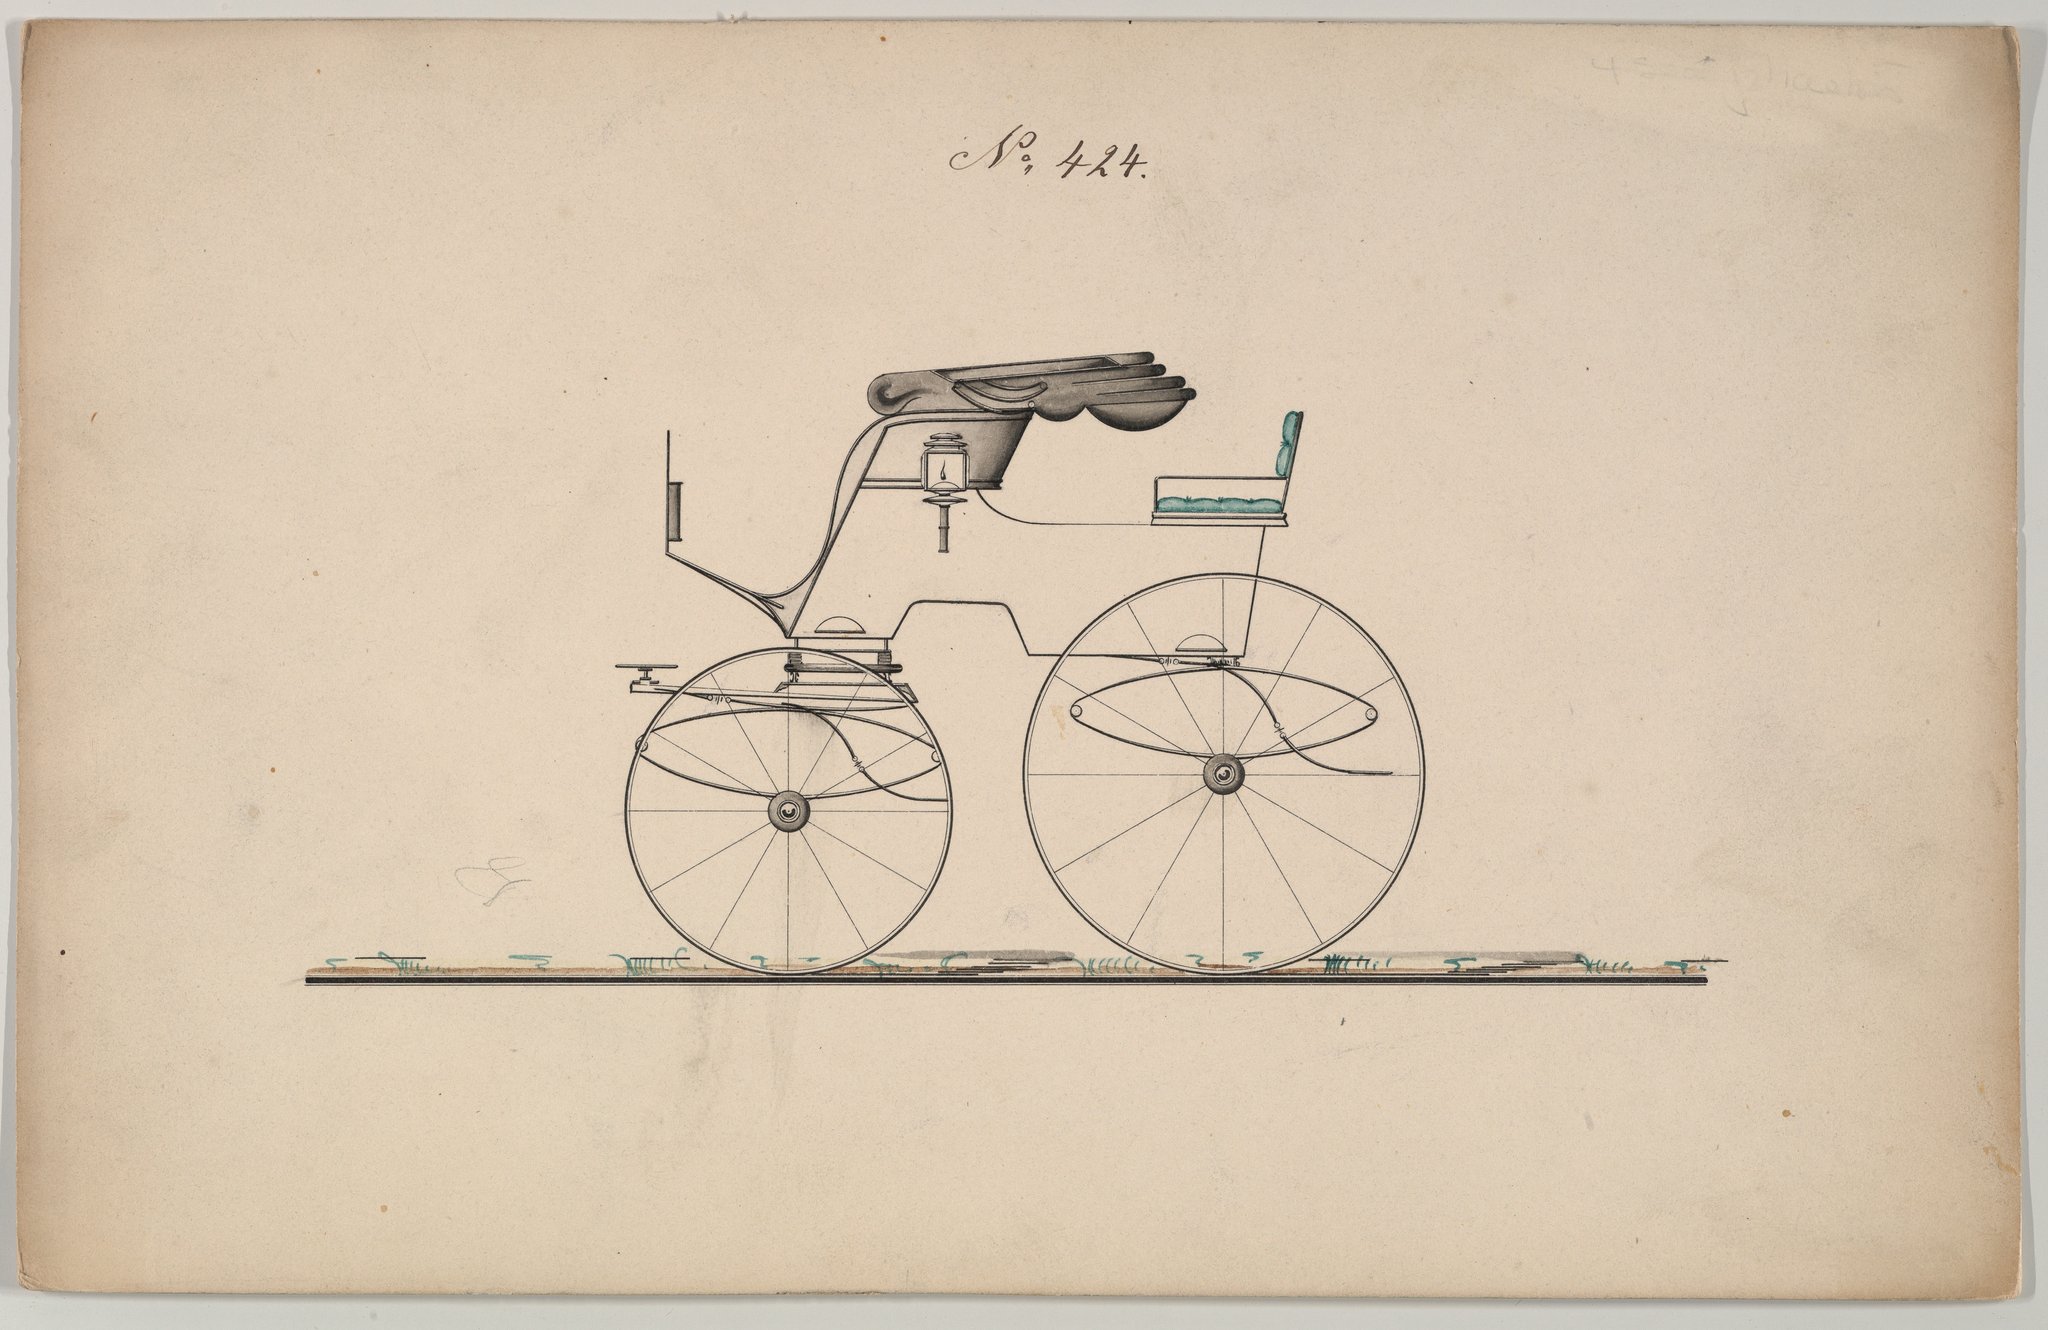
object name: drawing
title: Design for Stanhope Phaeton, no. 424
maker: brewster & co.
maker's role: manufacturer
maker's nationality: american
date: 1850-1874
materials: gouache, ink, watercolor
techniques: pen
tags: carriages